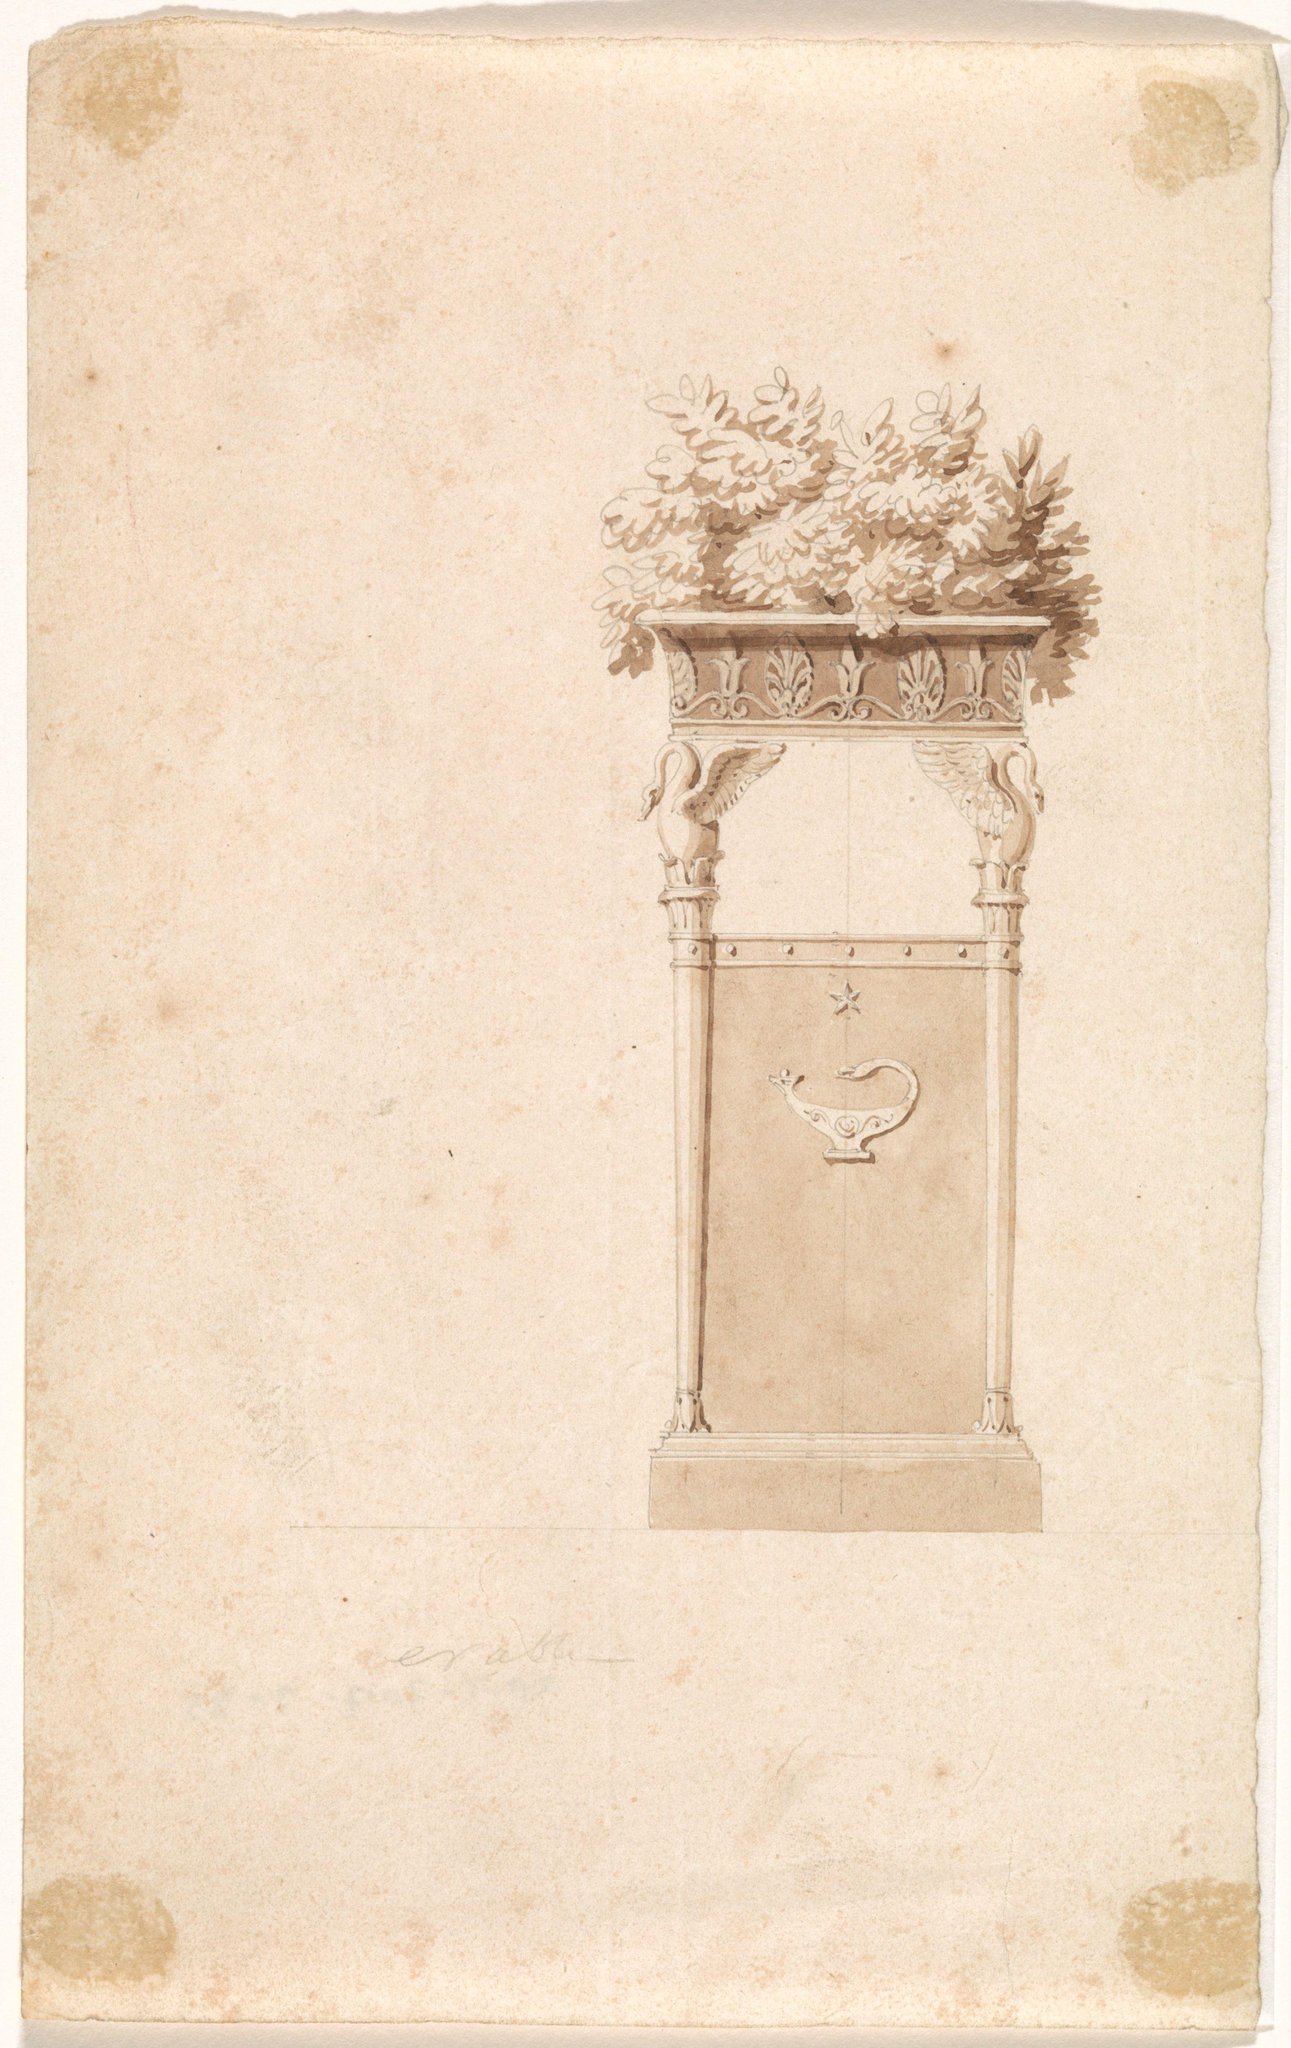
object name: drawing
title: Jardinière met versiering olielamp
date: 1805-1815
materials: graphite, paper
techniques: brush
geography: paris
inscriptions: watermark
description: Jardinière met door zwanen bekroonde poten en een versiering van een olielamp.